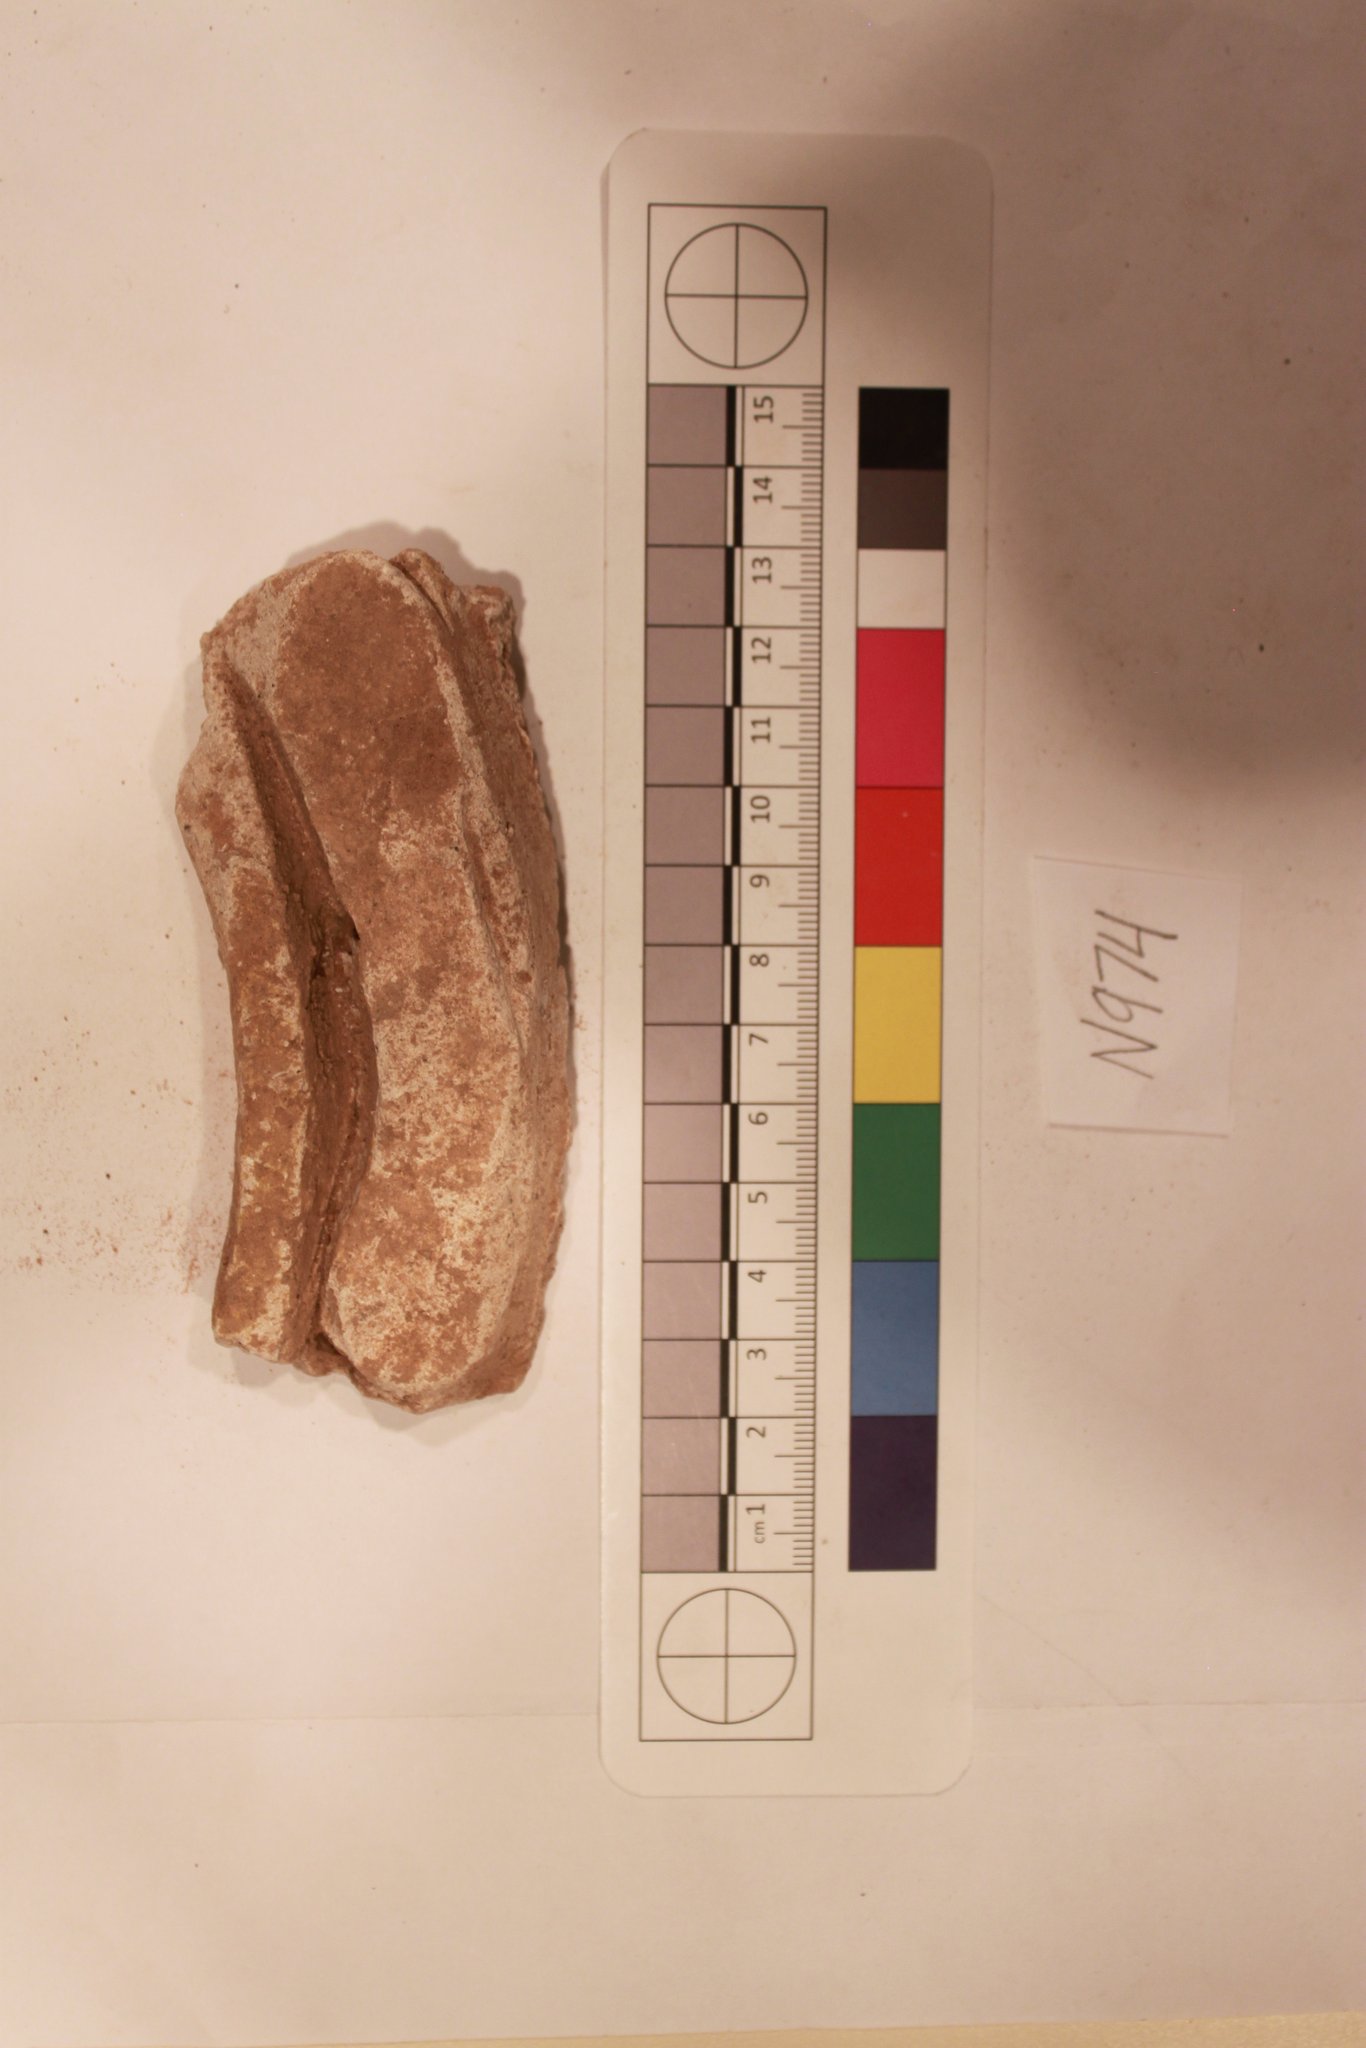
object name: fragment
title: Stucco Fragment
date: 701-1200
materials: plaster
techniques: carving, painting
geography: iran